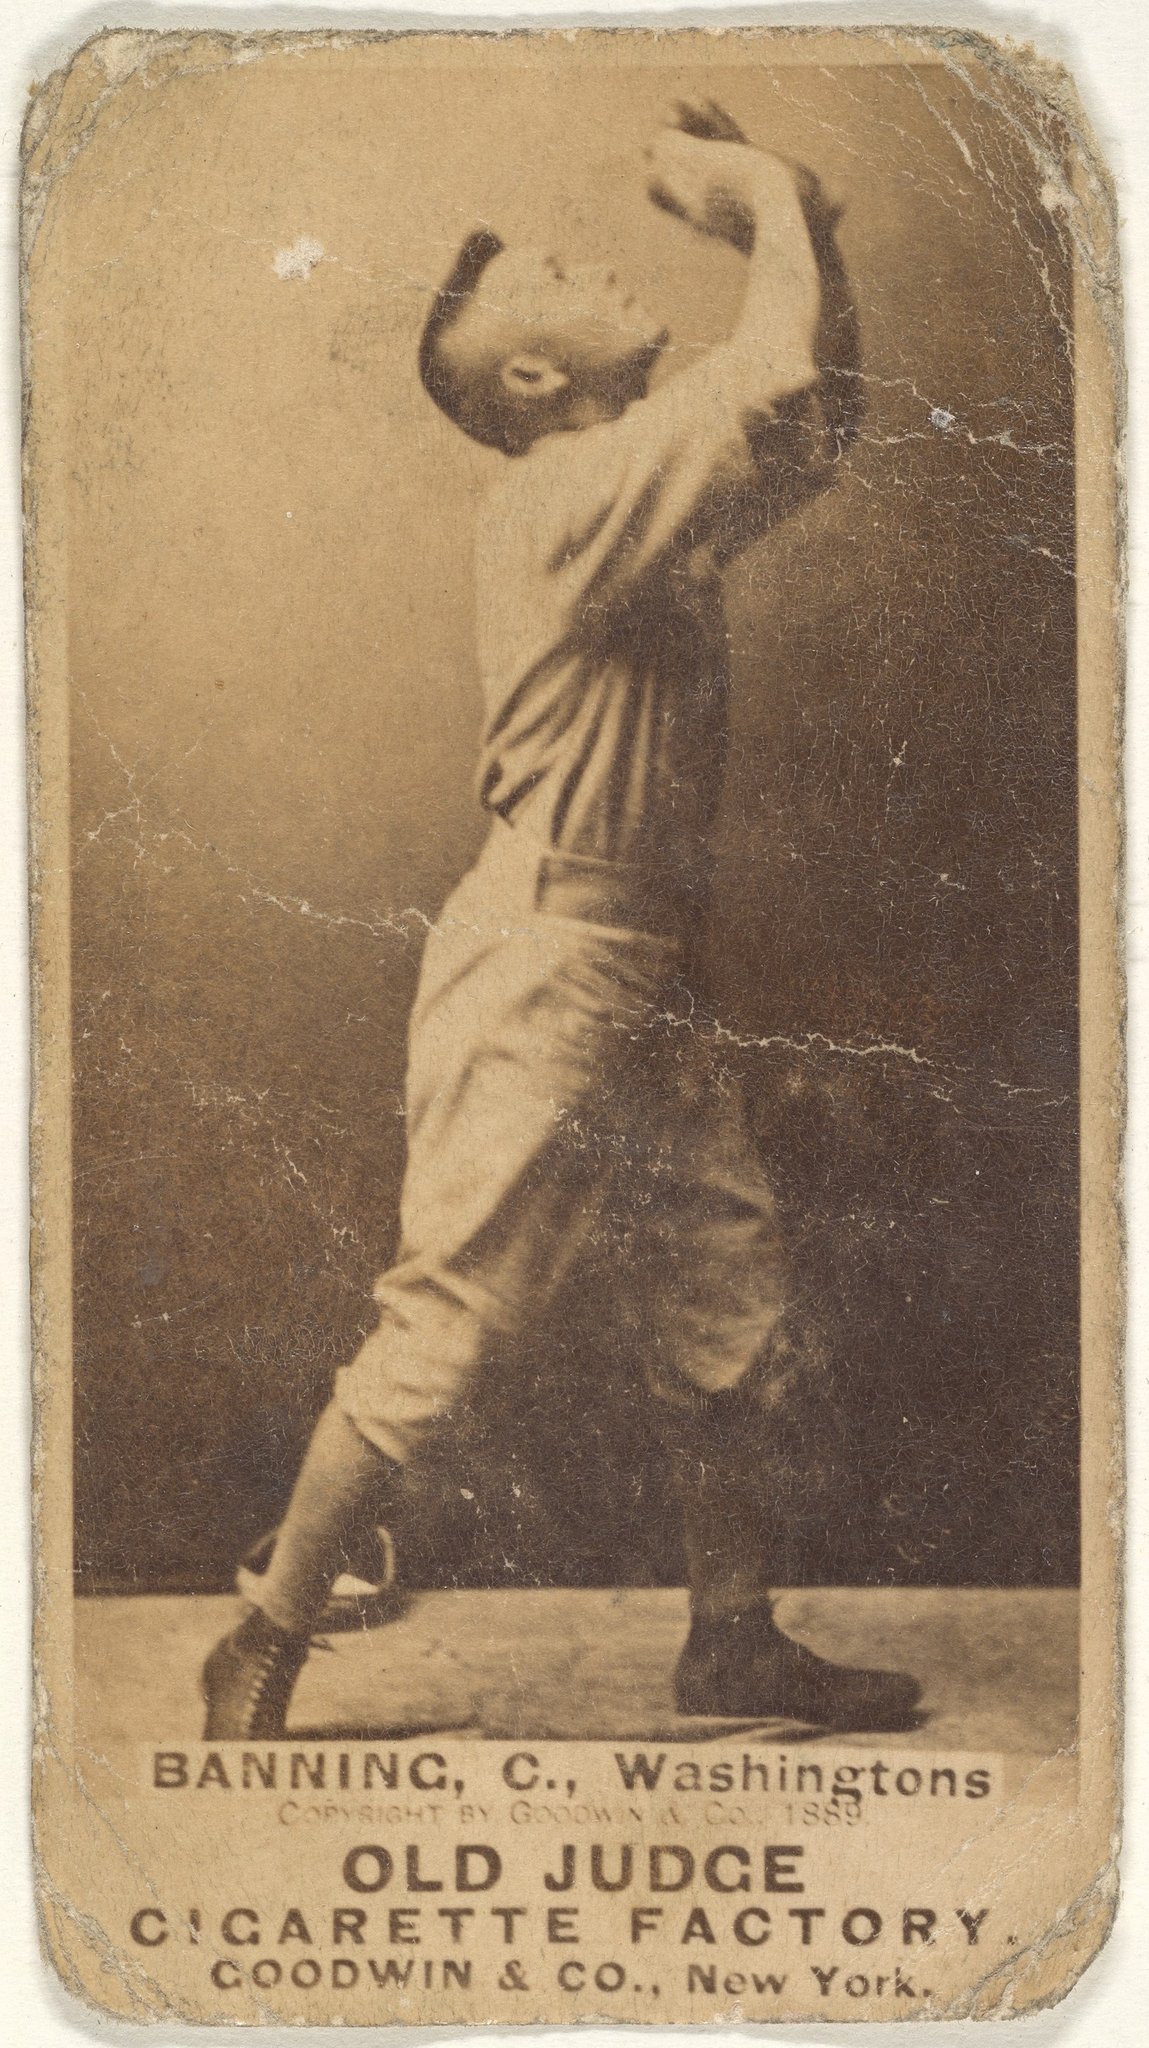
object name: baseball card, photograph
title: James "Jim" M. Banning, Catcher, Washington Nationals, from the Old Judge series (N172) for Old Judge Cigarettes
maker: goodwin & company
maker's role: publisher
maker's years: 1850-1950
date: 1889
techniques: albumen silver print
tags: men,portraits,baseball,athletes